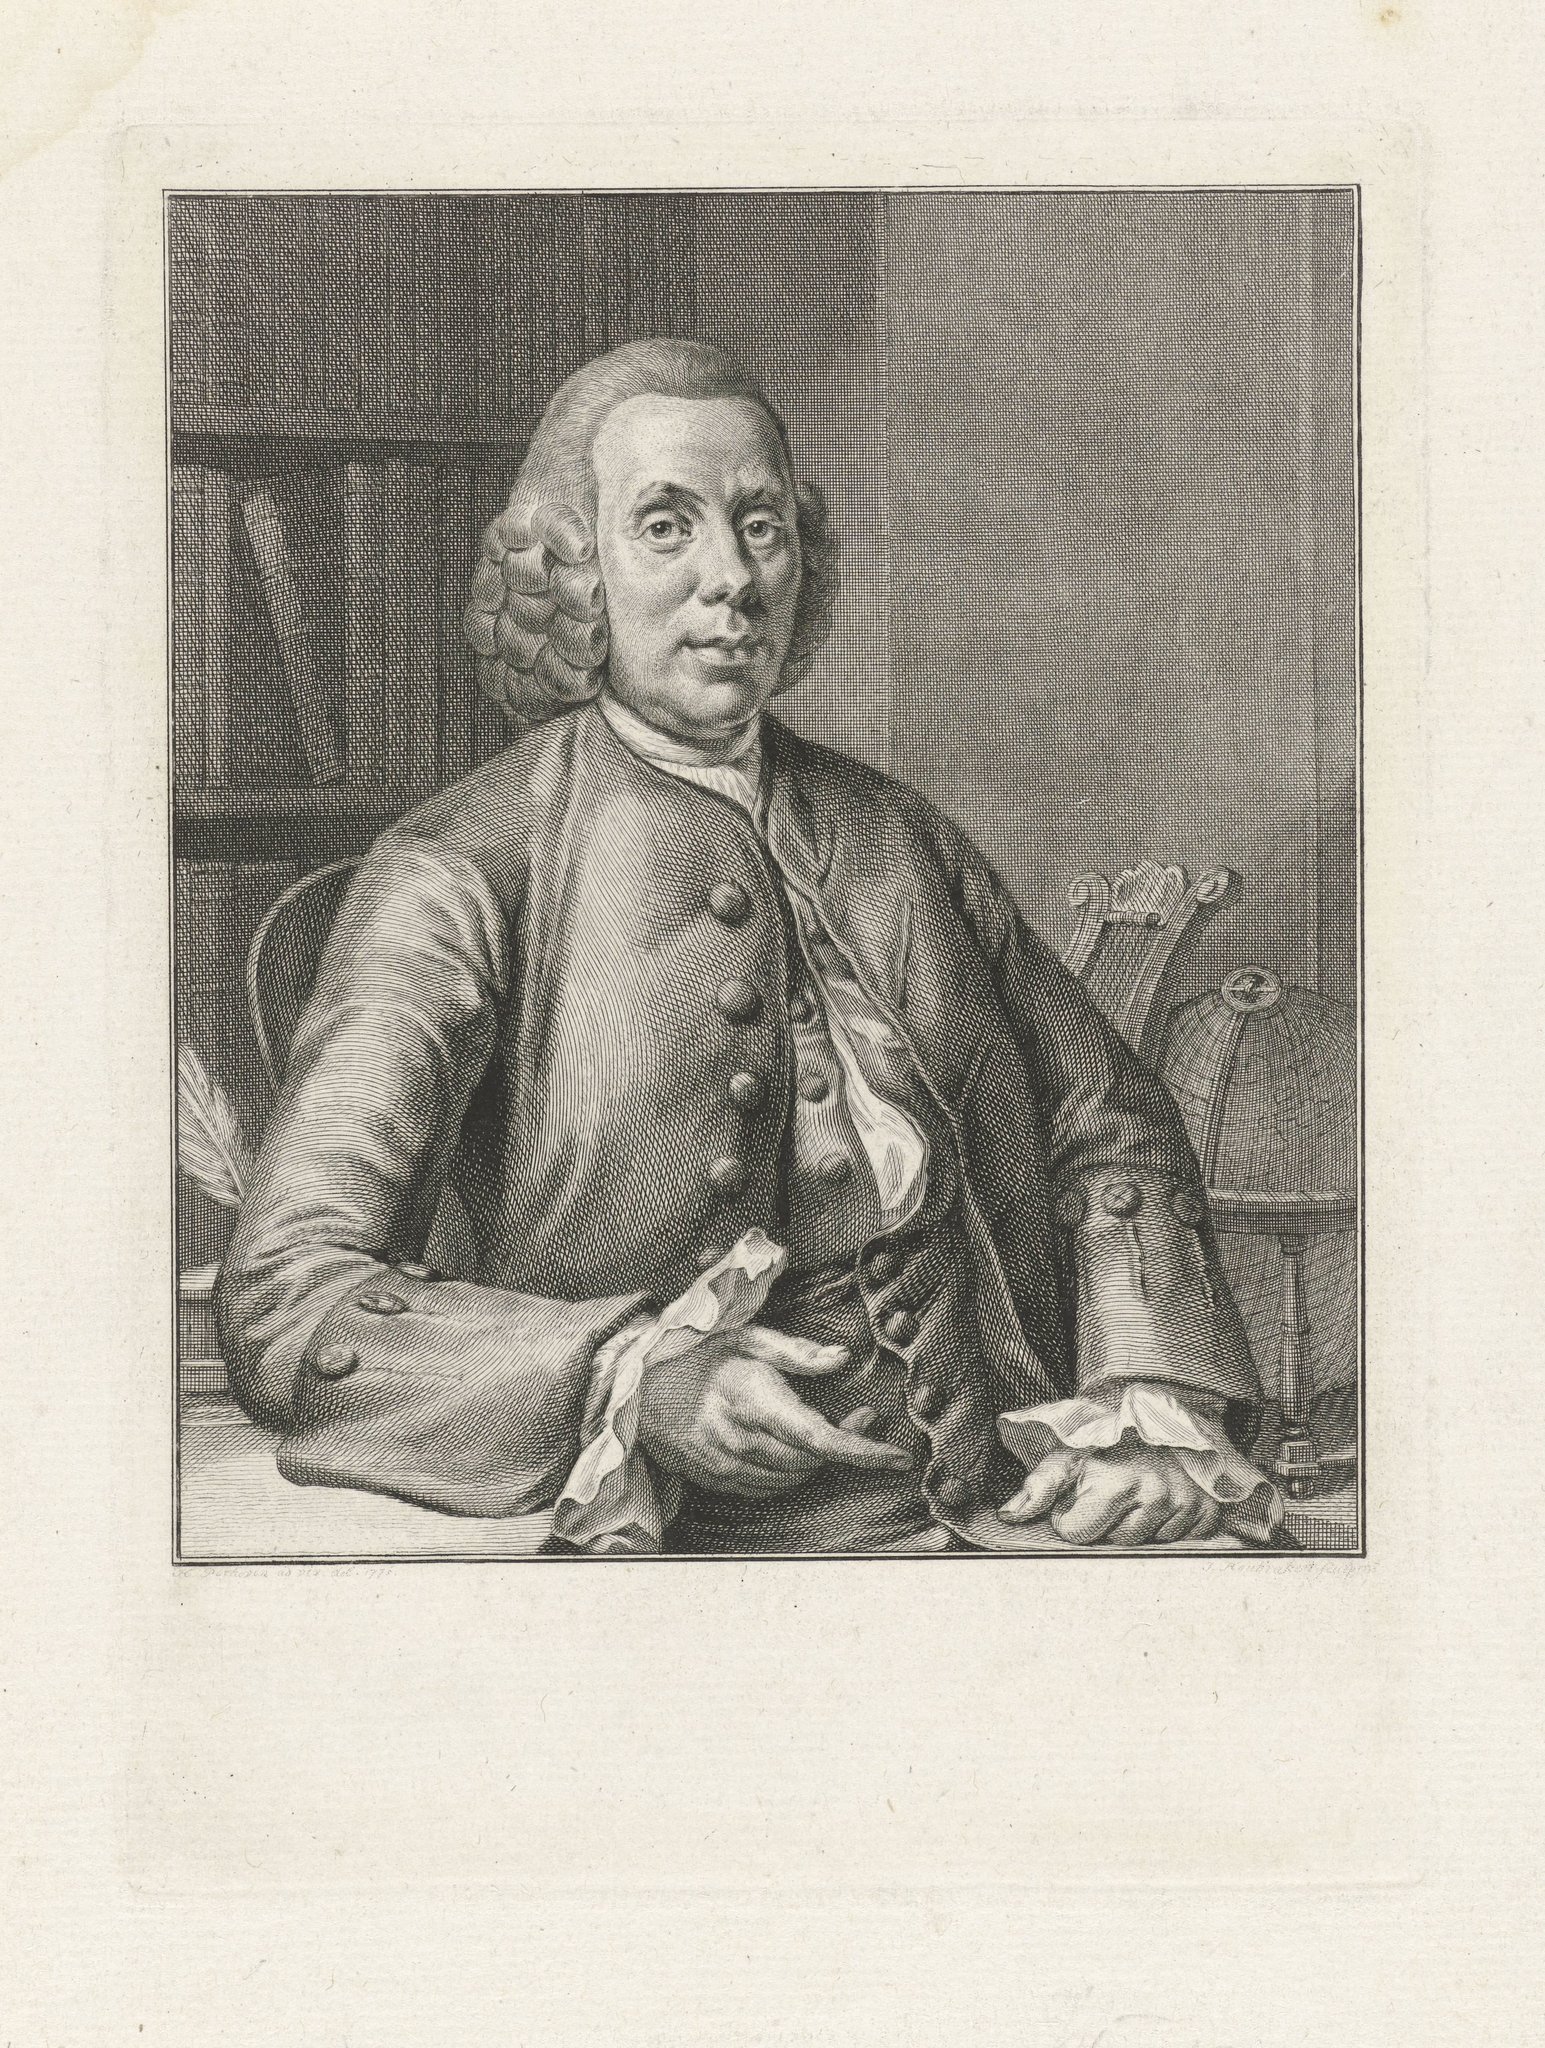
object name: print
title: Portret van Nicolaas Simon van Winter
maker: jacob houbraken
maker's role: draughtsman, print maker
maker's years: 1698-1780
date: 1771-1773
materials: paper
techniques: engraving, etching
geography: amsterdam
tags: nicolaas simon van winter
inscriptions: collector's mark: Lugt 2228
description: Portret van de dichter Nicolaas Simon van Winter.